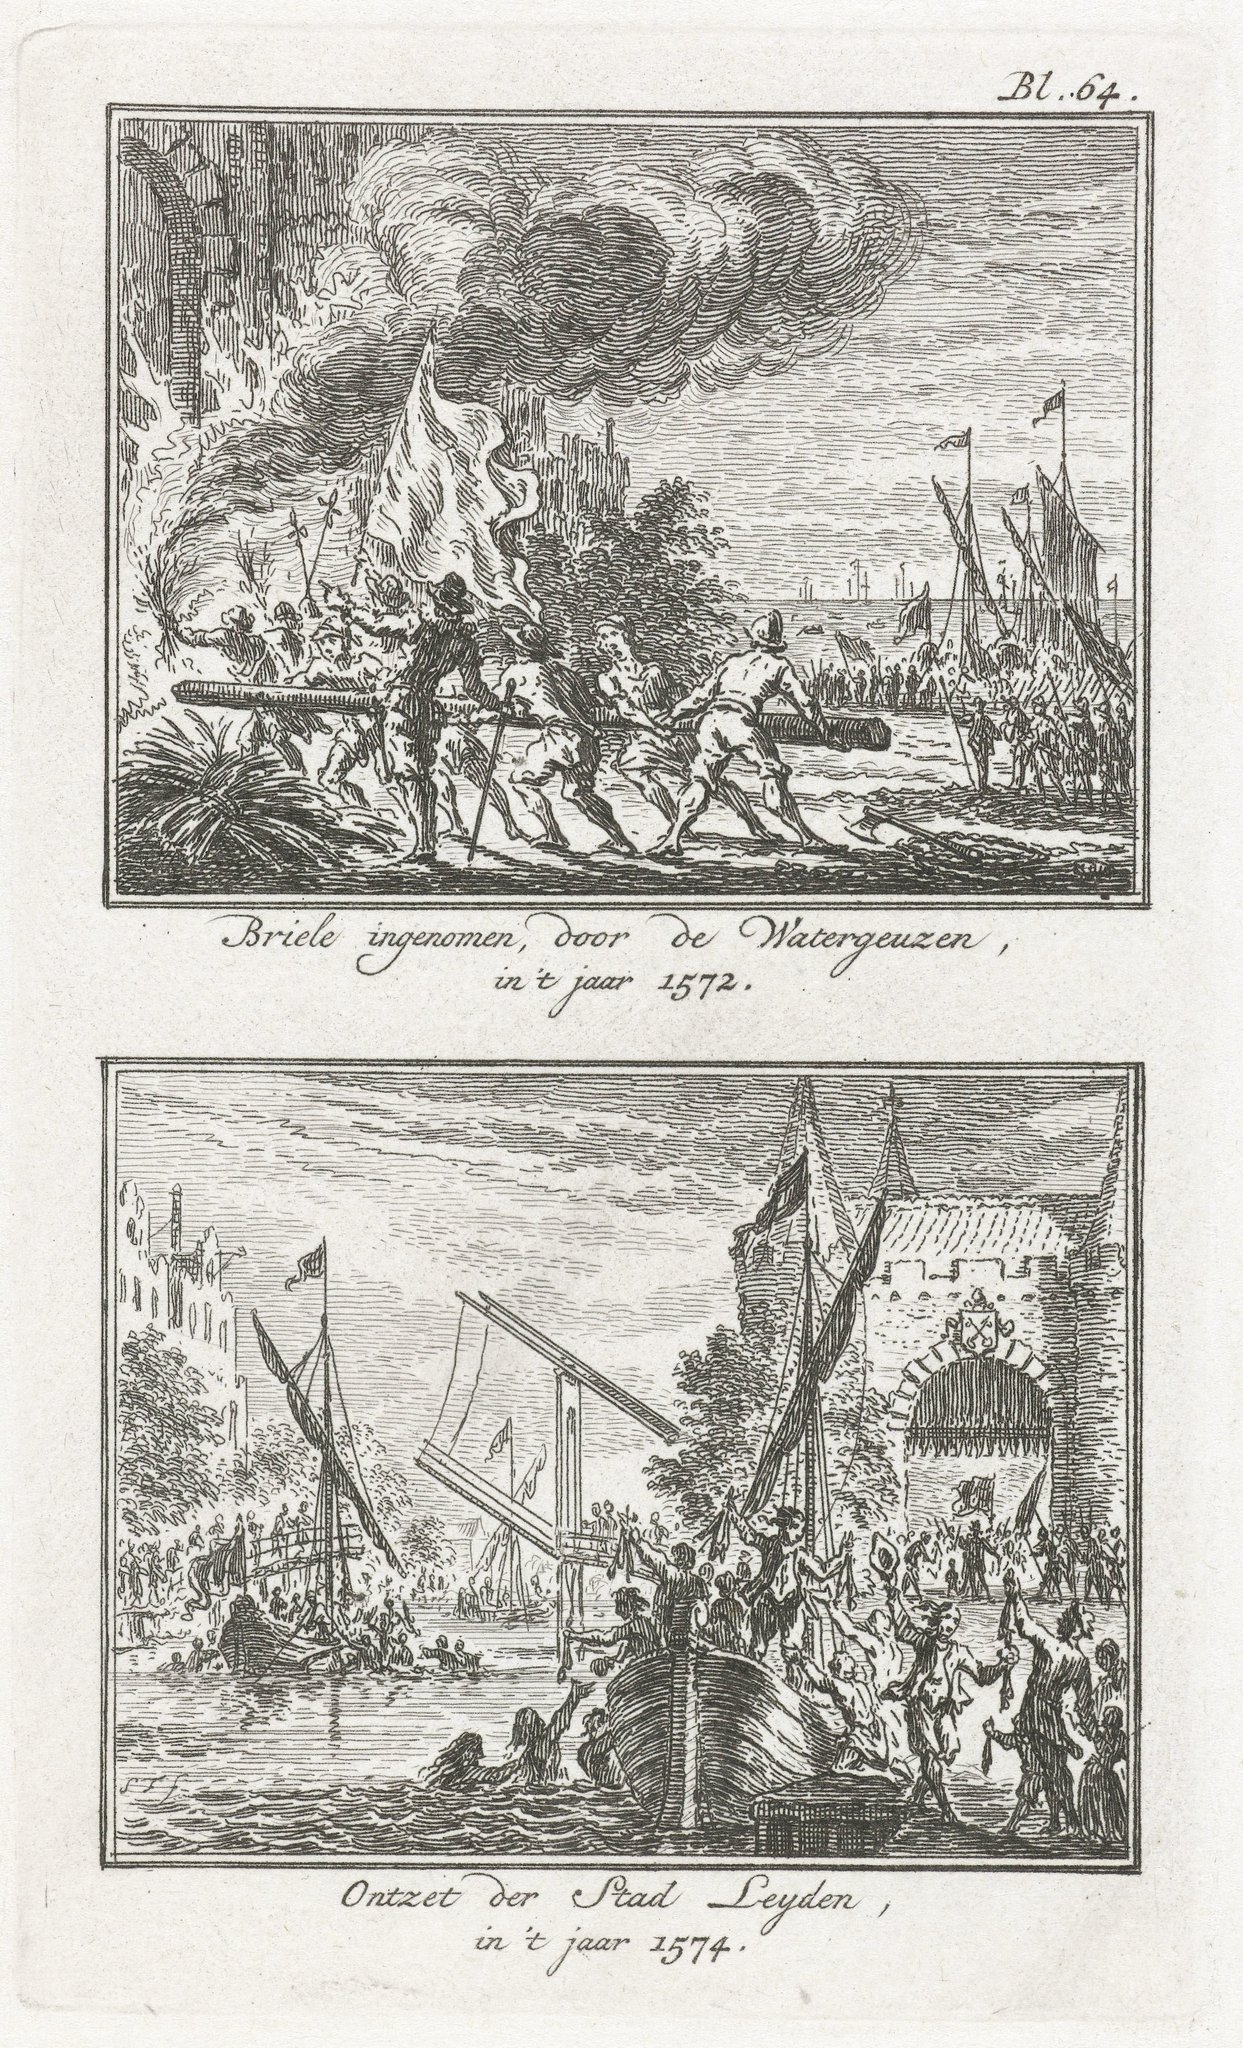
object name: print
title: Illustraties vaderlandse geschiedenis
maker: simon fokke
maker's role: draughtsman, print maker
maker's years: 1712-1784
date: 1752-1782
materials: paper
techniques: etching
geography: amsterdam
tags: raising the siege with outside assistance, relief, capture of city (after the siege), leiden, brielle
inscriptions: collector's mark: Lugt 2228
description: Voorstellingen uit de vaderlandse geschiedenis. Boven: Gezicht op de stadspoort van Brielle en het omliggende land tijdens de inname door de Watergeuzen. Op de achtergrond de zee met schepen. Onder: Vanuit de geuzenbootjes wordt eten uitgedeeld aan de inwoners van de stad tijdens het Leids Ontzet . Rechts een stadspoort. Twee voorstellingen van één plaat, rechtsboven gemerkt: Bl. 64.